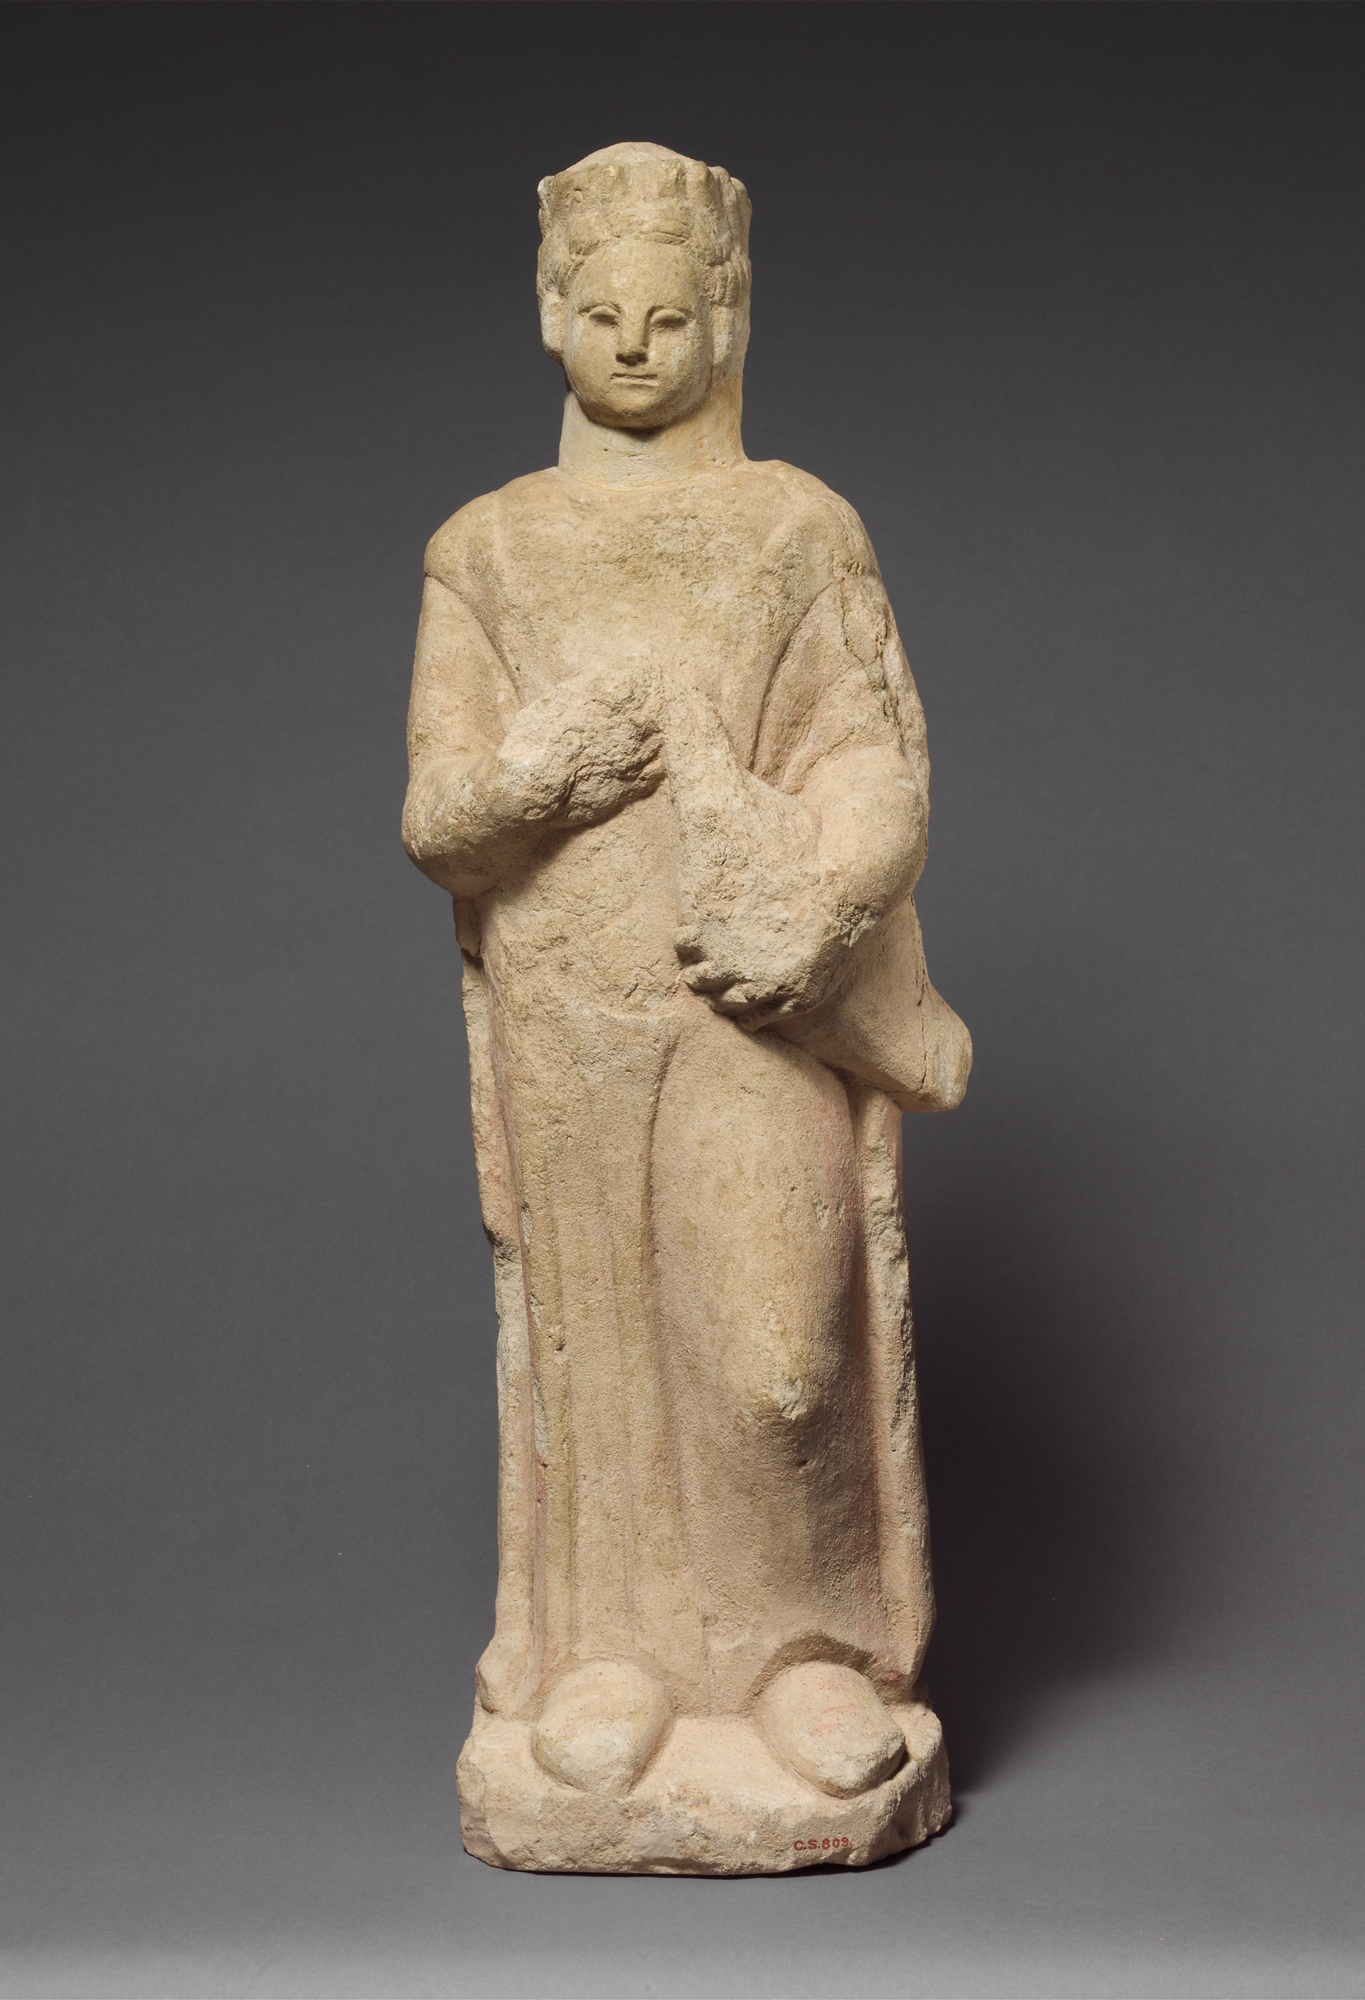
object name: statue of a goddess or votary with bird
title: Limestone statuette of a boy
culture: cypriot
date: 334-1 BCE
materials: limestone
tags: birds,boys